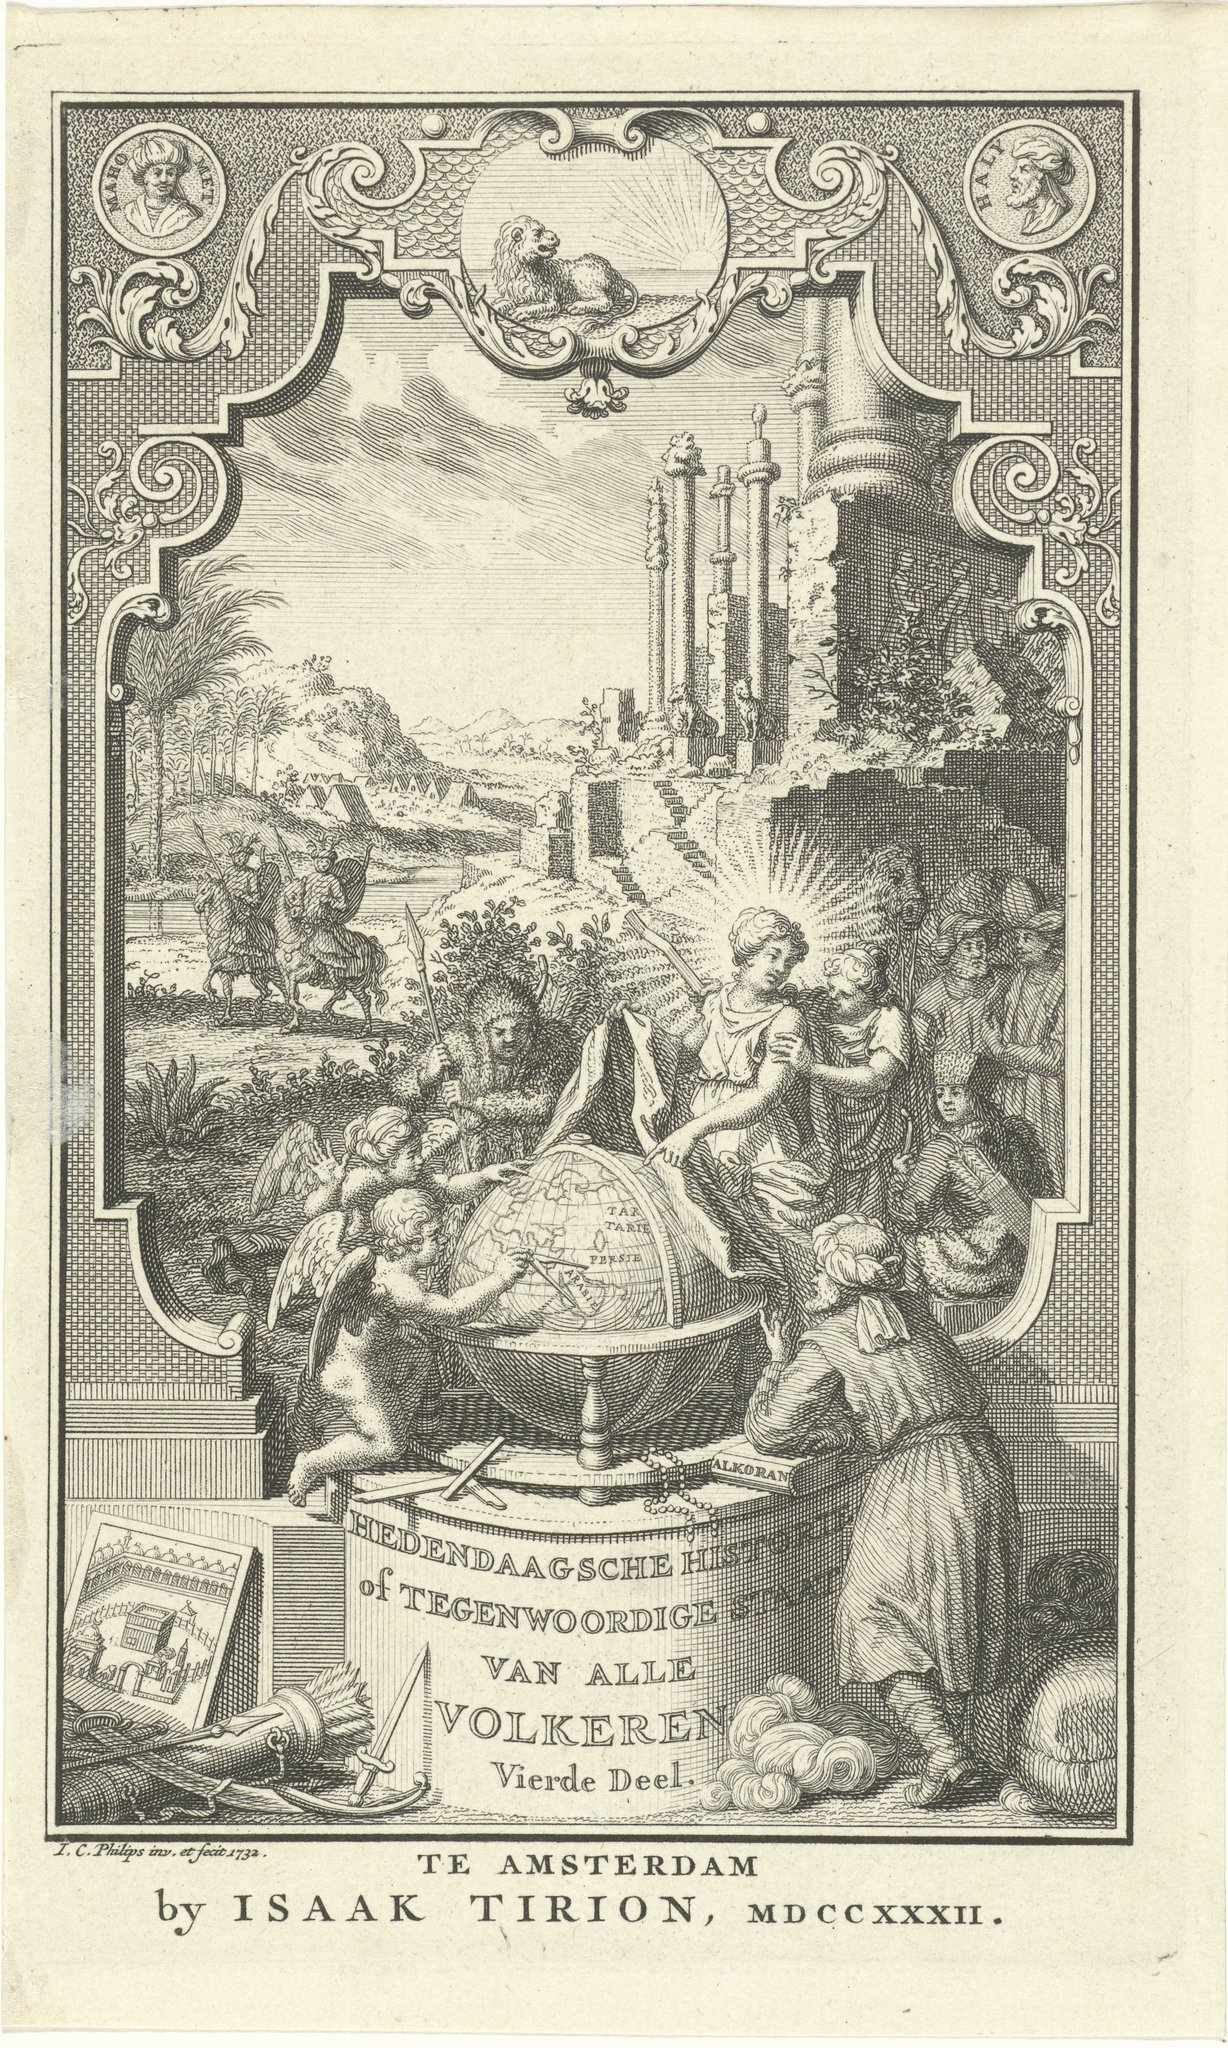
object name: titelblad, titelpagina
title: Titelpagina voor: Thomas Salmon, Hedendaagsche historie, of Tegenwoordige staat van alle volkeren, 1732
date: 1732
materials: paper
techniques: engraving, etching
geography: amsterdam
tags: islam, mohammedanism, landscapes in the non-temperate zone, exotic landscapes - kk - ideal landscapes, landscape with ruins, globe, asiatic races and peoples: persians, asiatic races and peoples (with name)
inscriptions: collector's mark: Lugt 2228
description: Een samengesteld landschap met de ruïne van een antieke tempel. Op de voorgrond hebben zich mensen uit ‘Arabië’, ‘Perzië’, ‘Tartarije’ en putti rond een globe geschaard. Links een schilderij waarop de Kaäba te Mekka afgebeeld is. Op een piëdestal de titel in het Nederlands. De voorstelling is gevat in een cartouche met in de bovenhoeken in medaillons de portretten van twee heersers.